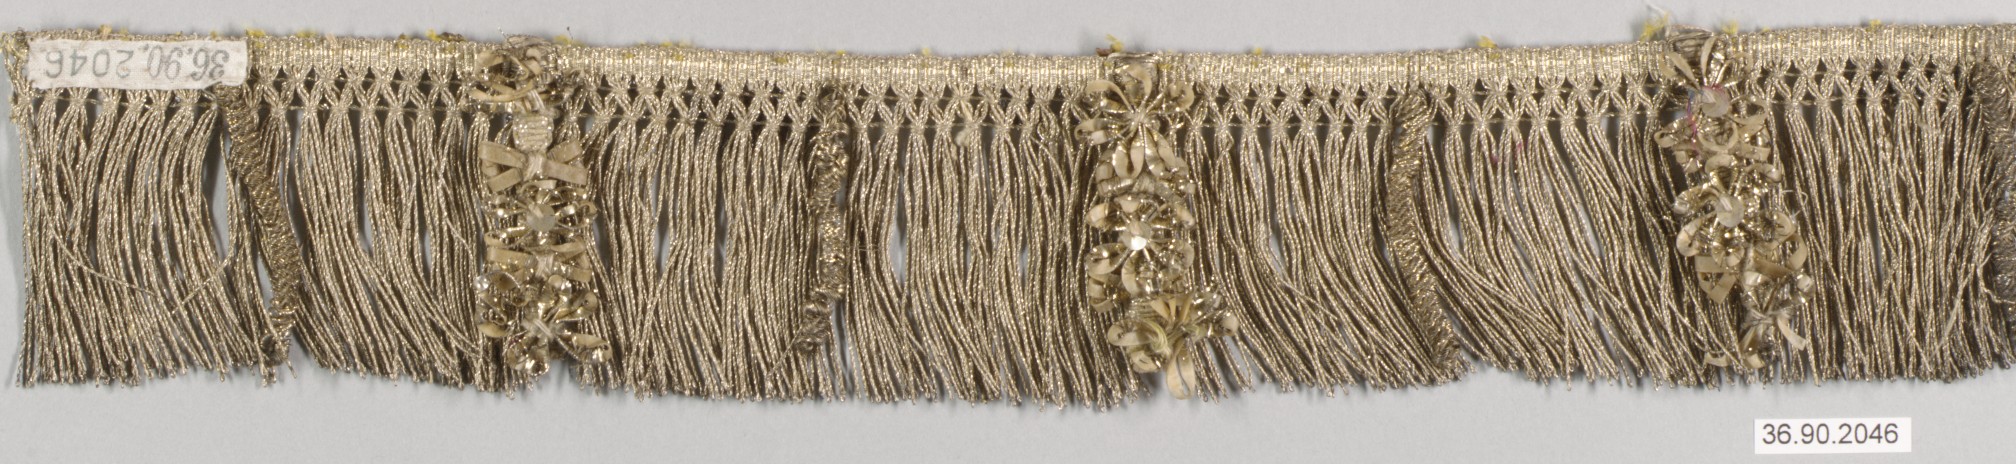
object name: fringe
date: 1867-1900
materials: metal thread